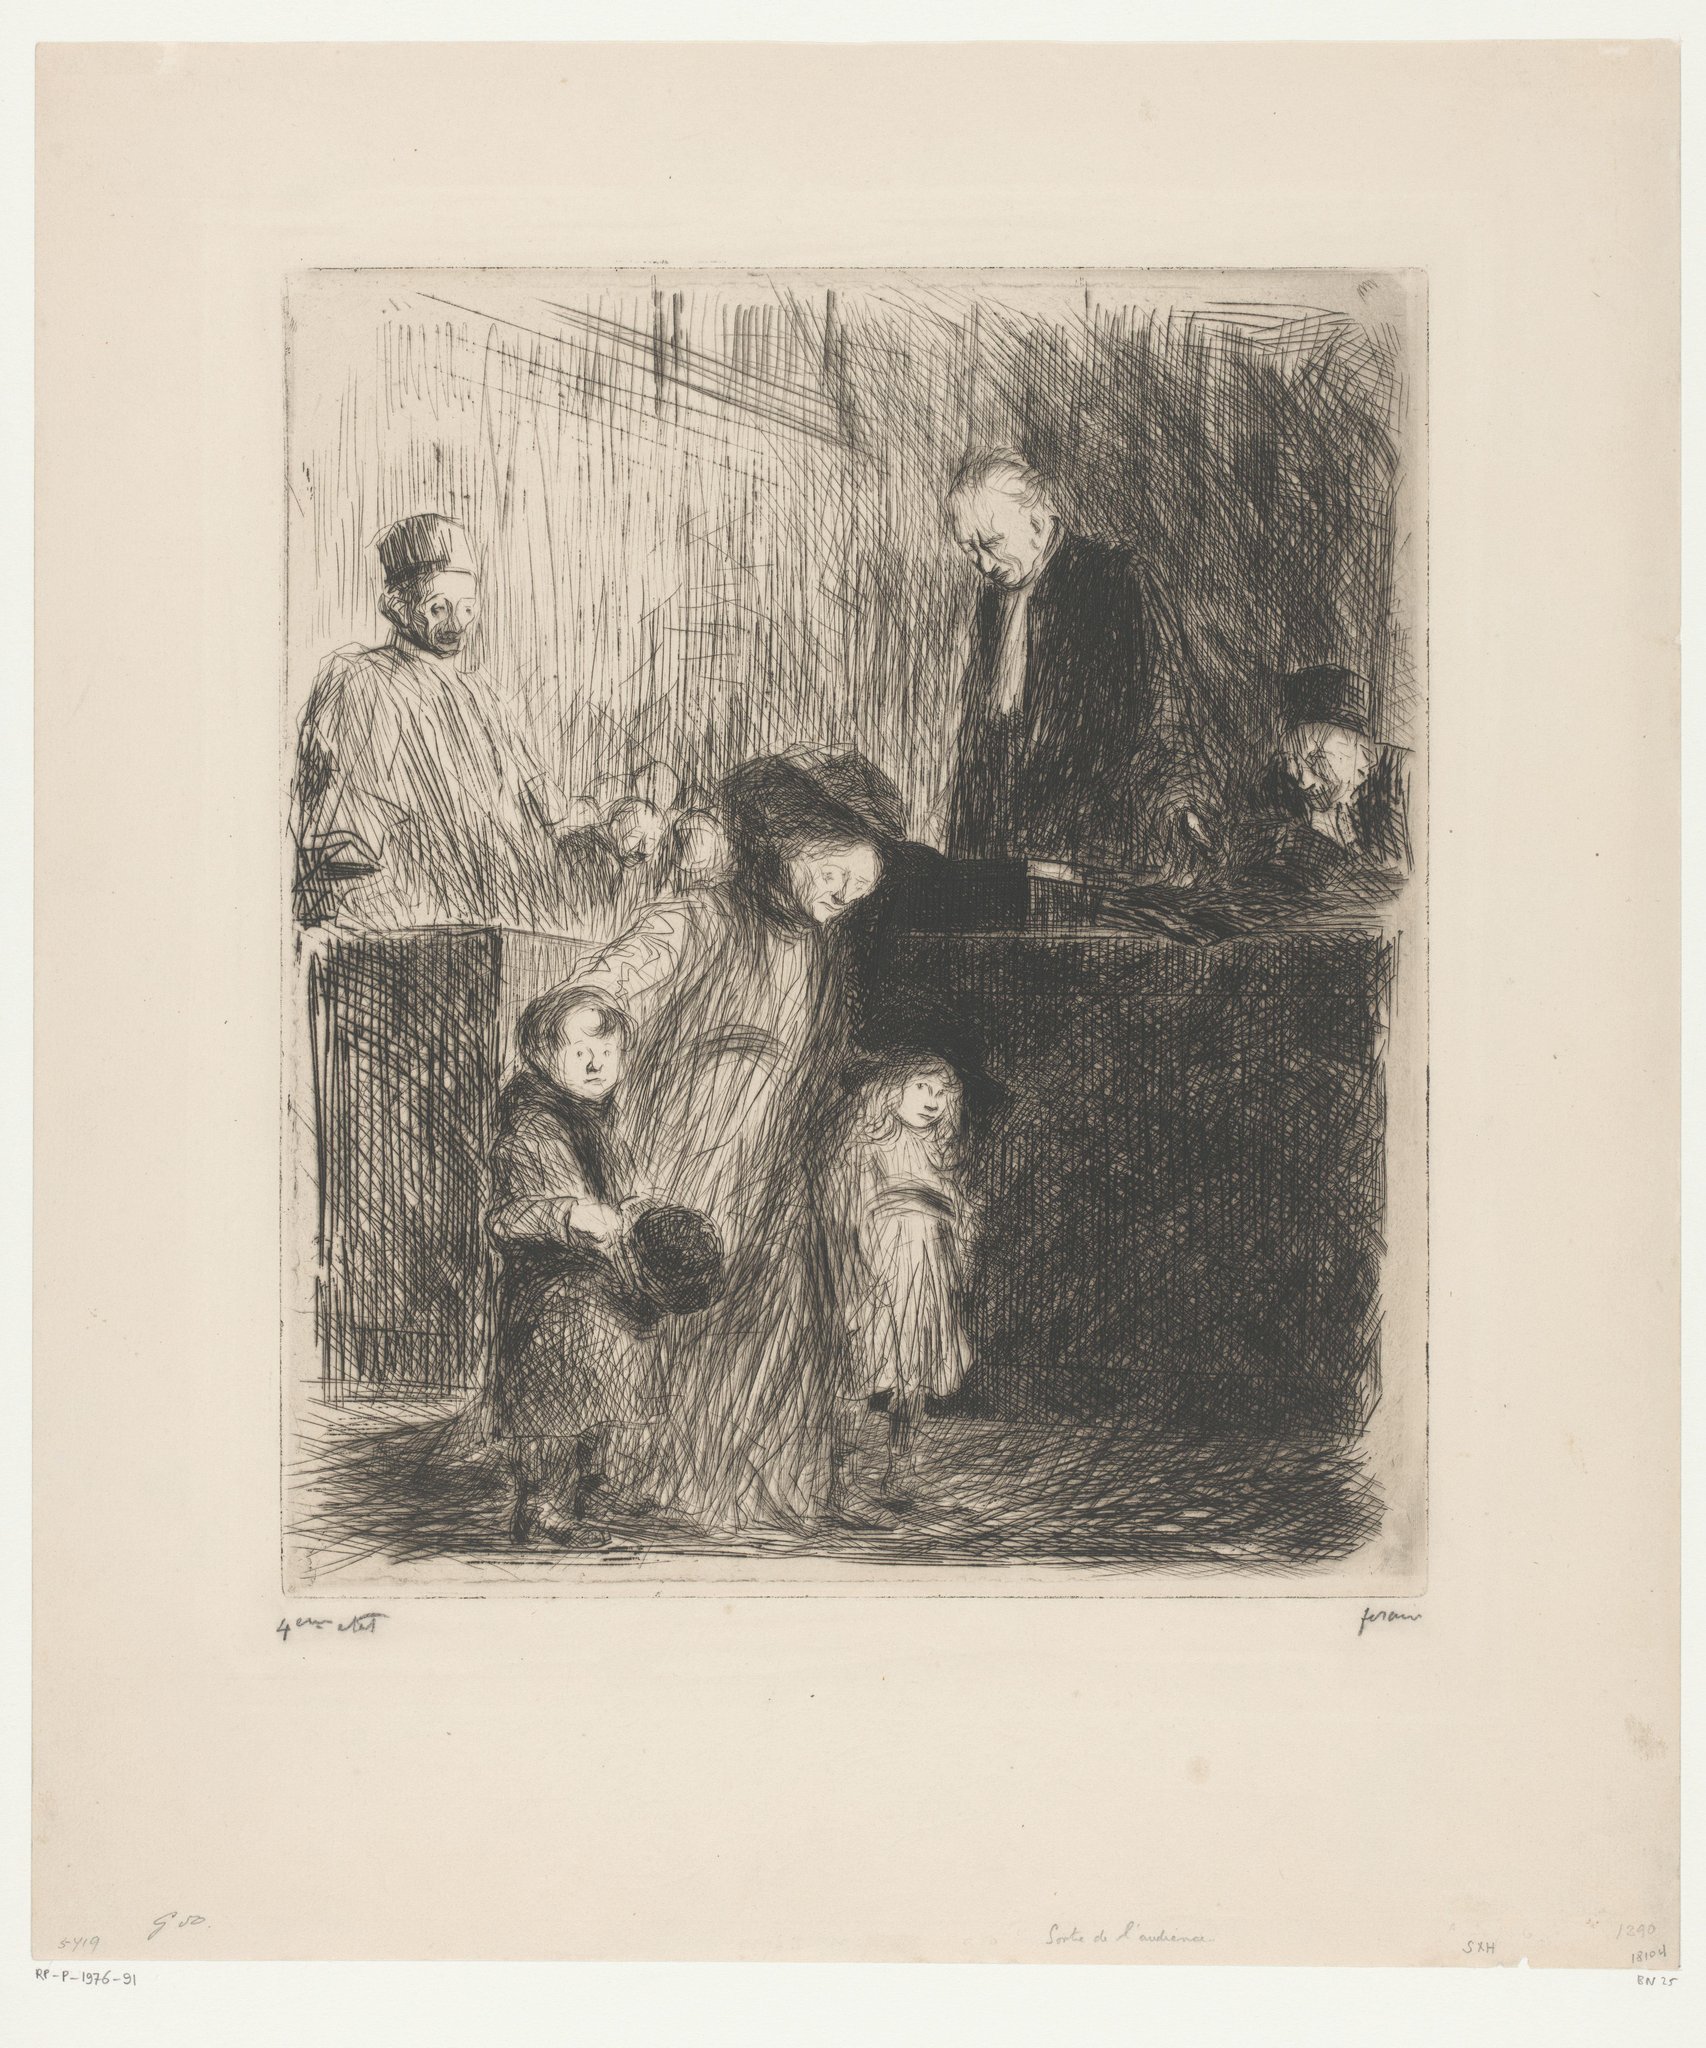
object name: print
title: Vrouw met twee jonge kinderen mogelijk een rechtszaal verlatend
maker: jean-louis forain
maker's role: painter, print maker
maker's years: 1852-1931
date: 1909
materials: paper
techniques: drypoint, etching, intaglio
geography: france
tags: child, court-room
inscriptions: collector's mark: Lugt 2228